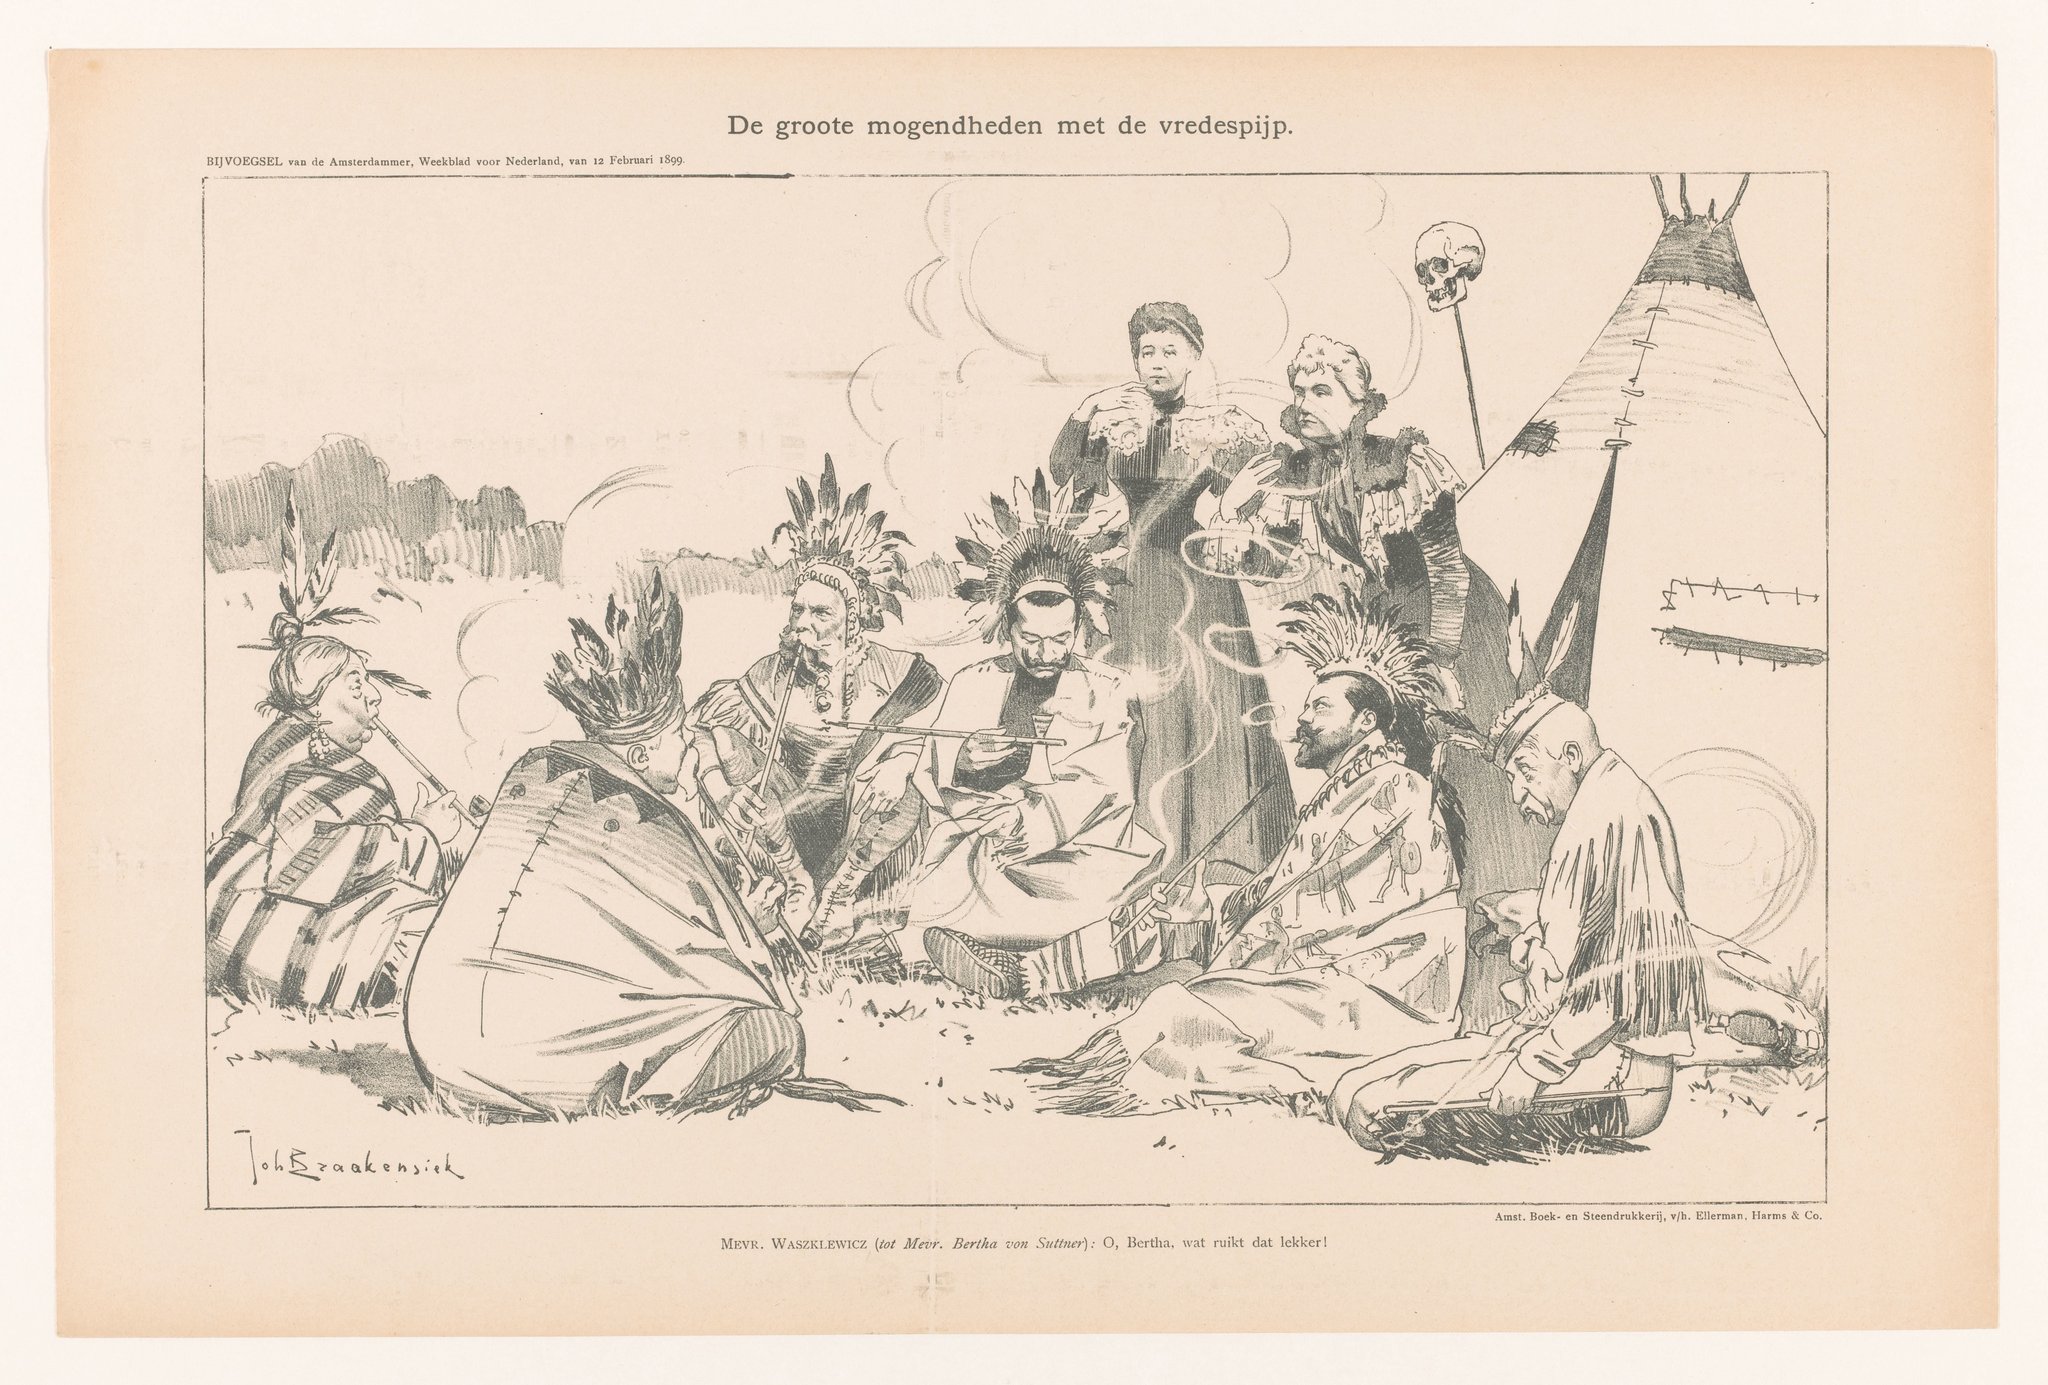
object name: cartoon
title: De groote mogendheden met de vredespijp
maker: johan braakensiek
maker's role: draughtsman, print maker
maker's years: 1858-1940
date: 1899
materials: paper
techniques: lithograph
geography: amsterdam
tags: wilhelm ii (keizer van duitsland), tepee, tipi, teepee, historical persons, pipe ~ tobacco, indigenous peoples of north america, ruler, sovereign, peace, political caricatures and satires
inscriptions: date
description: Leiders van Europese landen verkleed als stereotiepe oorspronkelijke bewoners van Noord-Amerika, roken de vredespijp zittend op de grond voor een tipi. Twee vrouwen van de internationale vredesbeweging kijken goedkeurend toe.